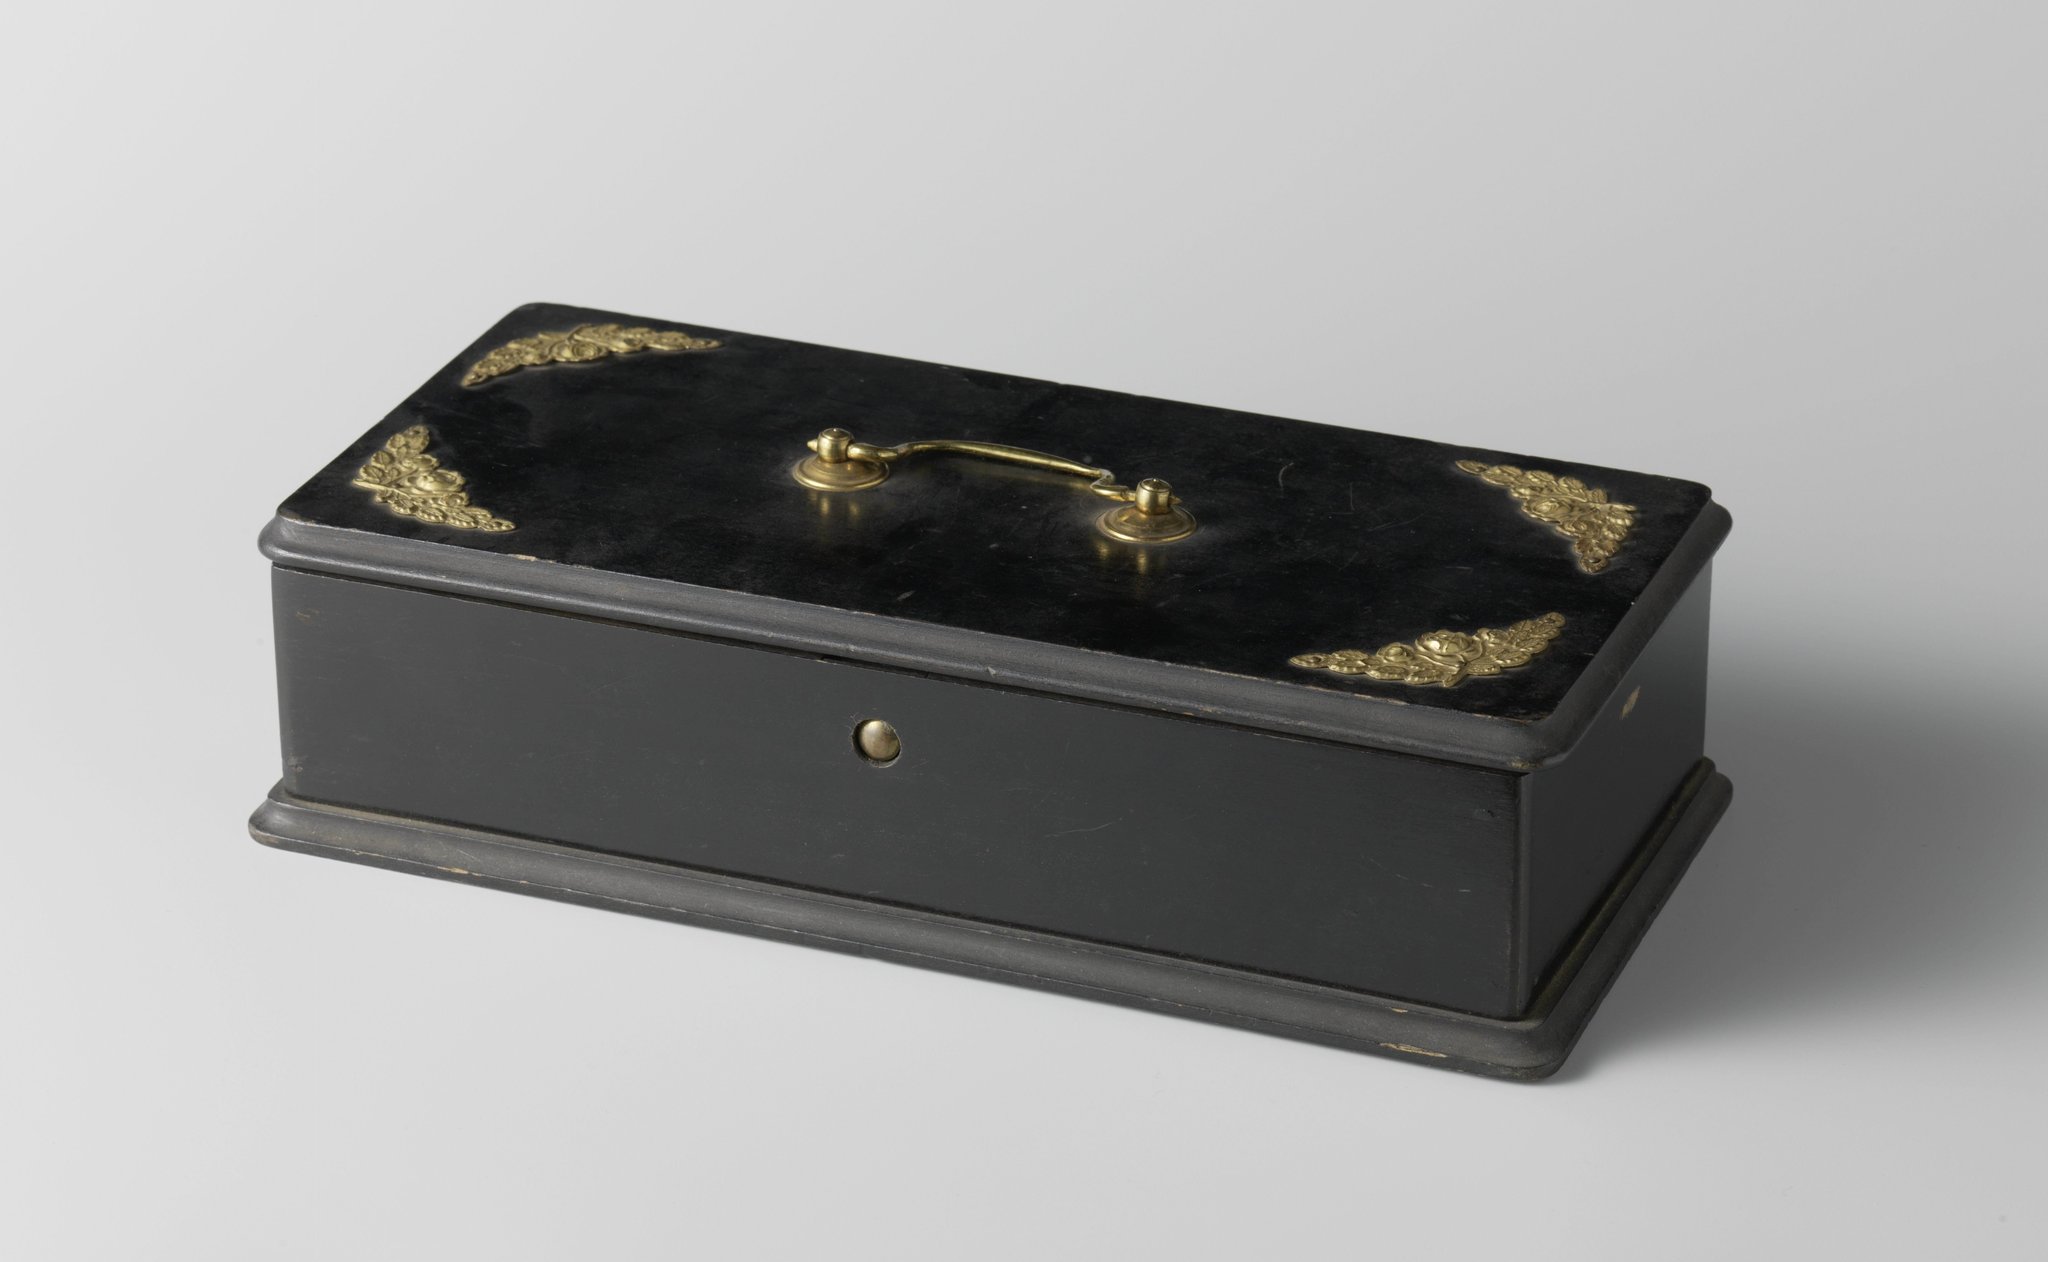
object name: chest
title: Casket with mementoes of Baron C.J. Krayenhoff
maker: Anonymous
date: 1895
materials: copper, iron, paper, wood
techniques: woodworking, lacquer, printing, striking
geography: netherlands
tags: c.j. baron krayenhoff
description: Cornelis Johannes Krayenhoff fought as a cavalry officer at the Battle of Waterloo. He was struck by a bullet and fell from his horse, but fortunately lived to tell the tale. Krayenhoff and his descendants imbued this event with heroism and martyrdom: they kept as family relics the cartridge case crushed by his fall and the bullet that struck him.